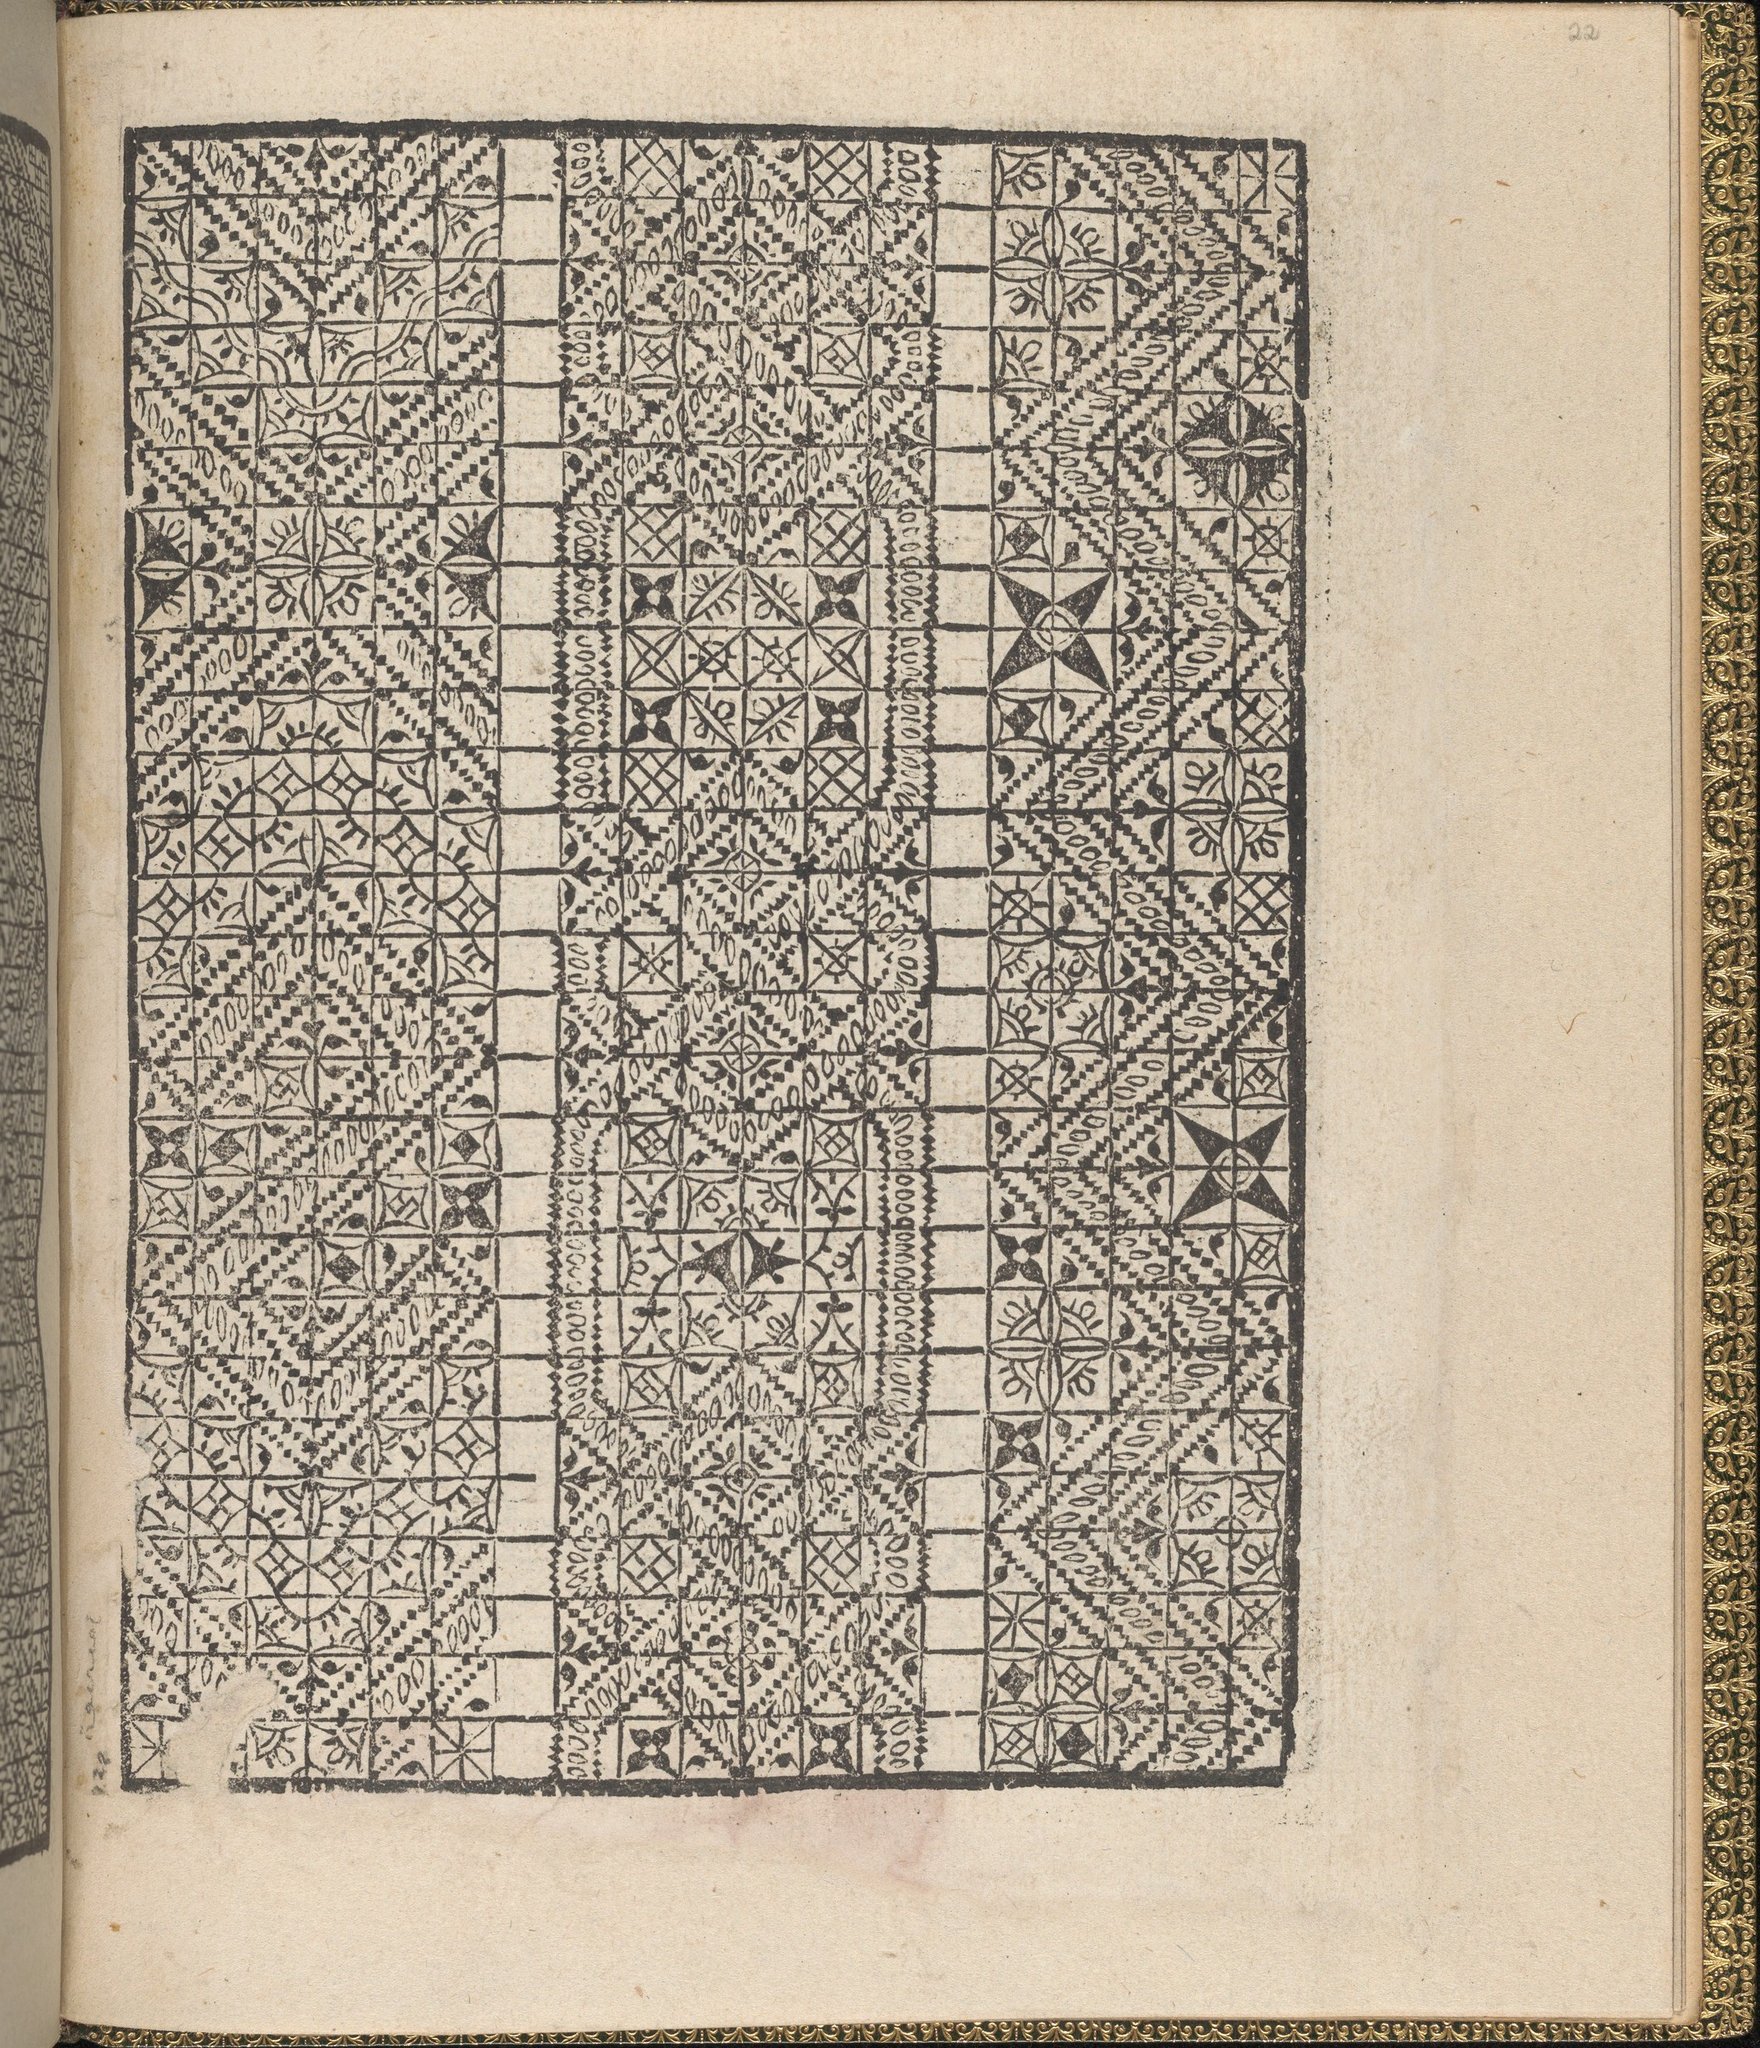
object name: book print ornament architecture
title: Giardineto novo di punti tagliati et gropposi per exercitio & ornamento delle donne (Venice 1554), page 12 (recto)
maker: matteo pagano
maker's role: publisher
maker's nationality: italian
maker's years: 1515-1588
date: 1554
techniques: woodcut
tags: ornament